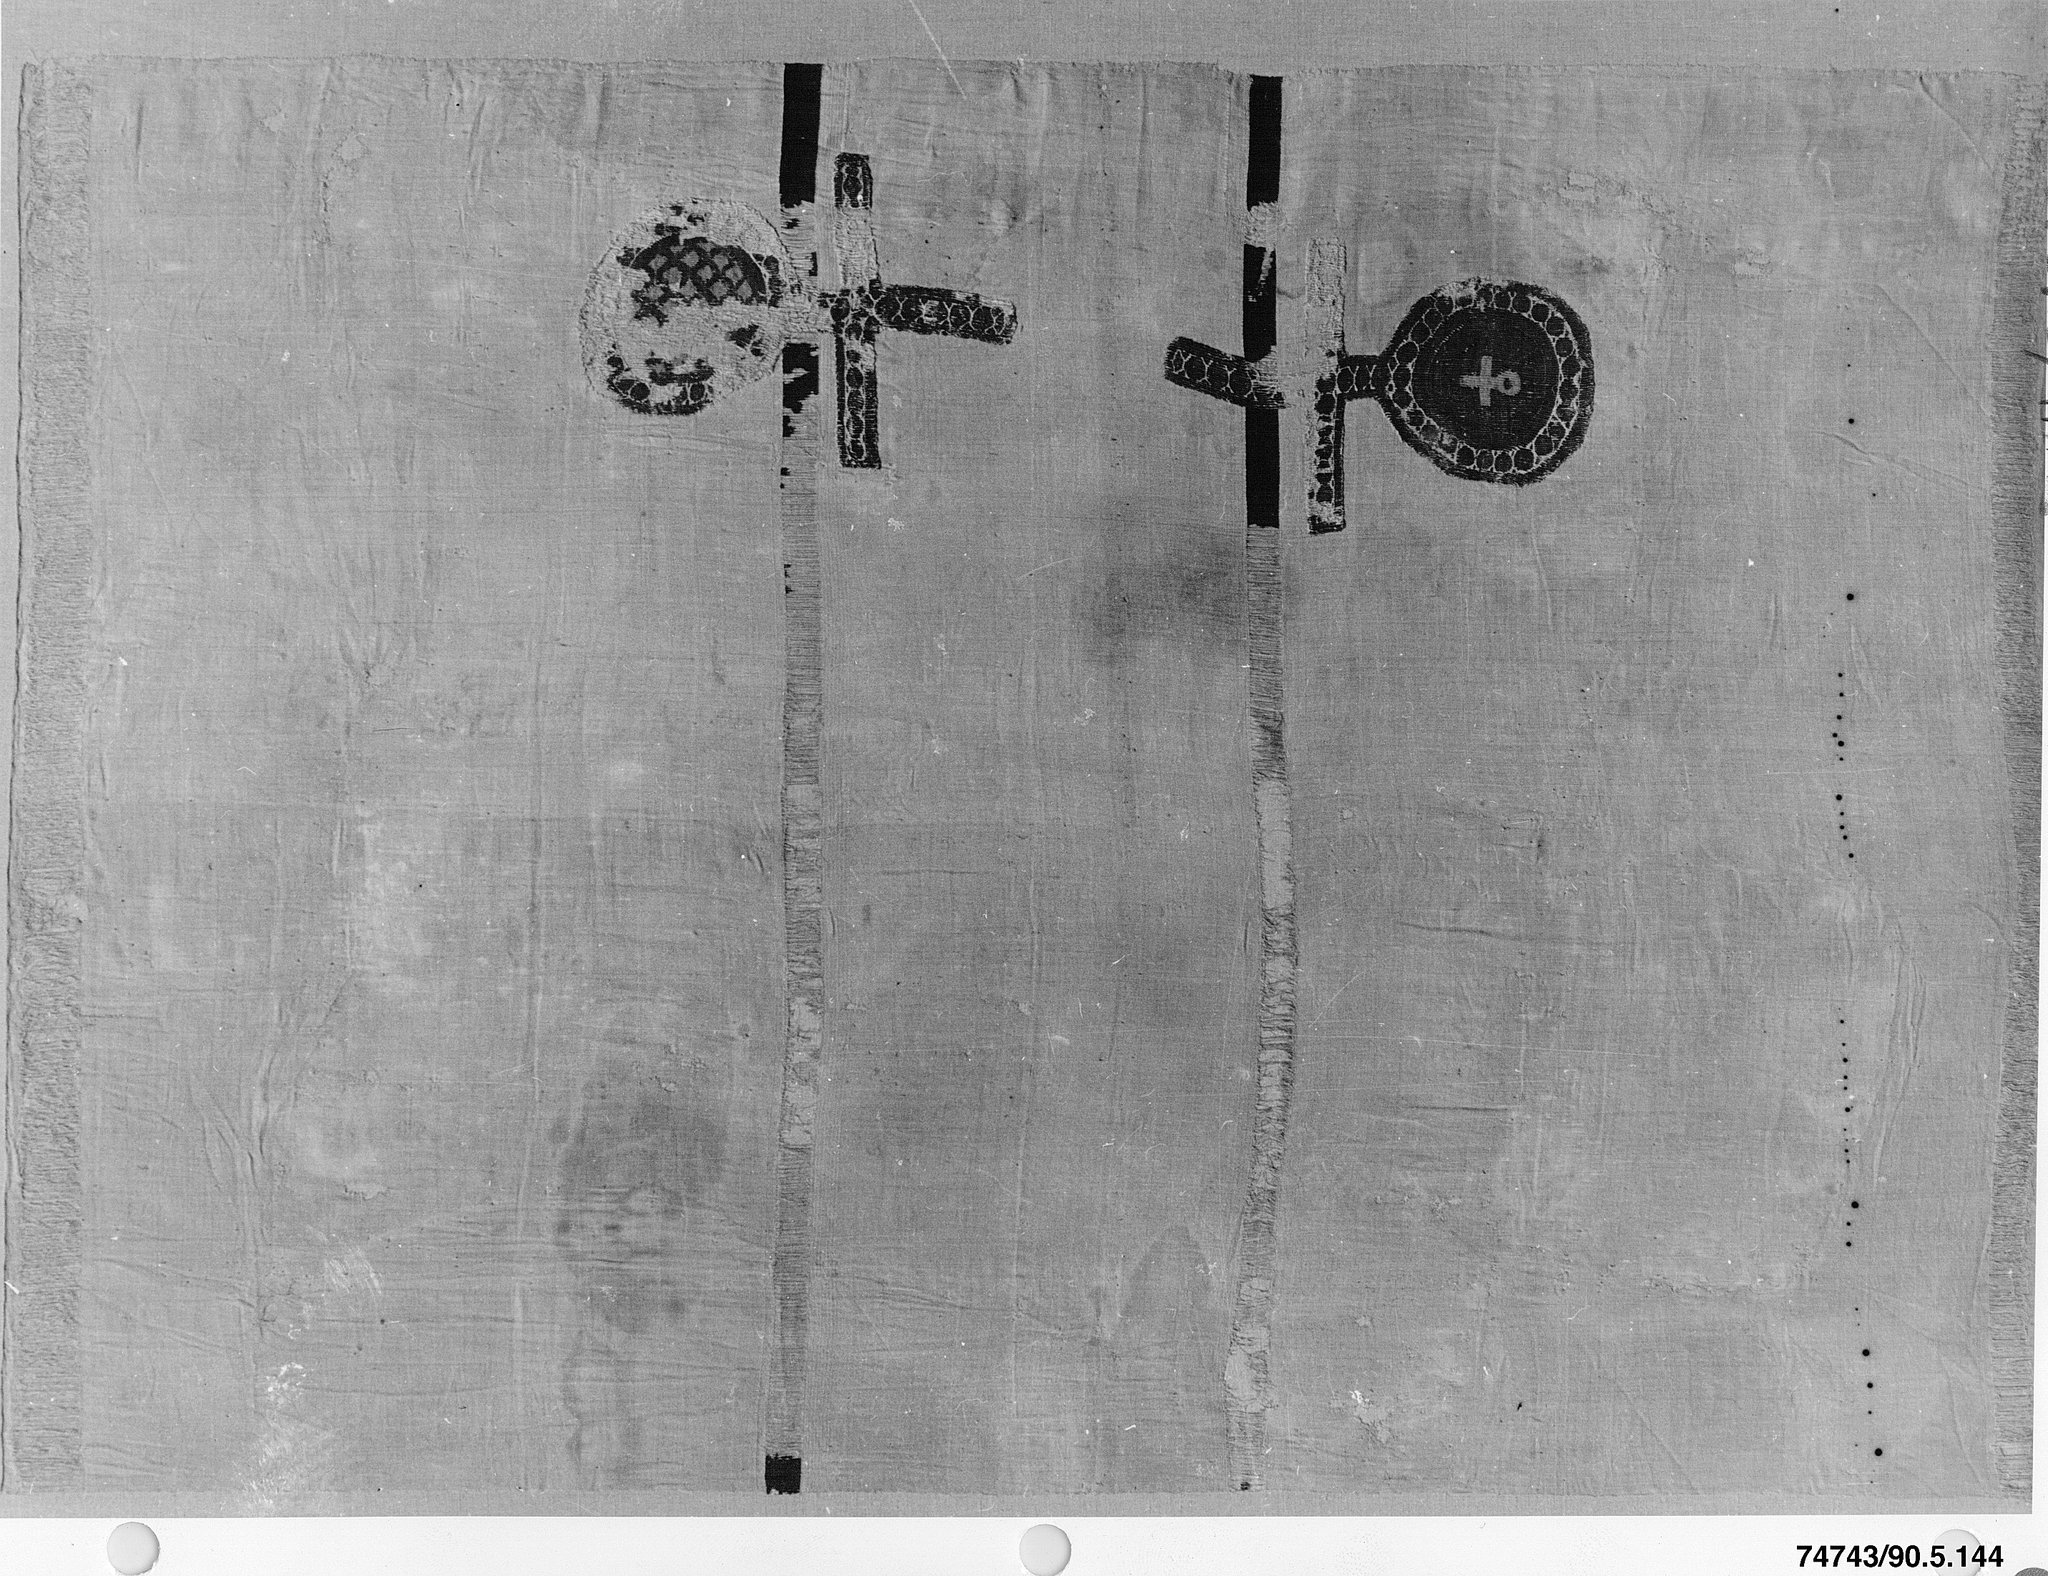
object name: length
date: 301-500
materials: linen, wool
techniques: weave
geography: egypt